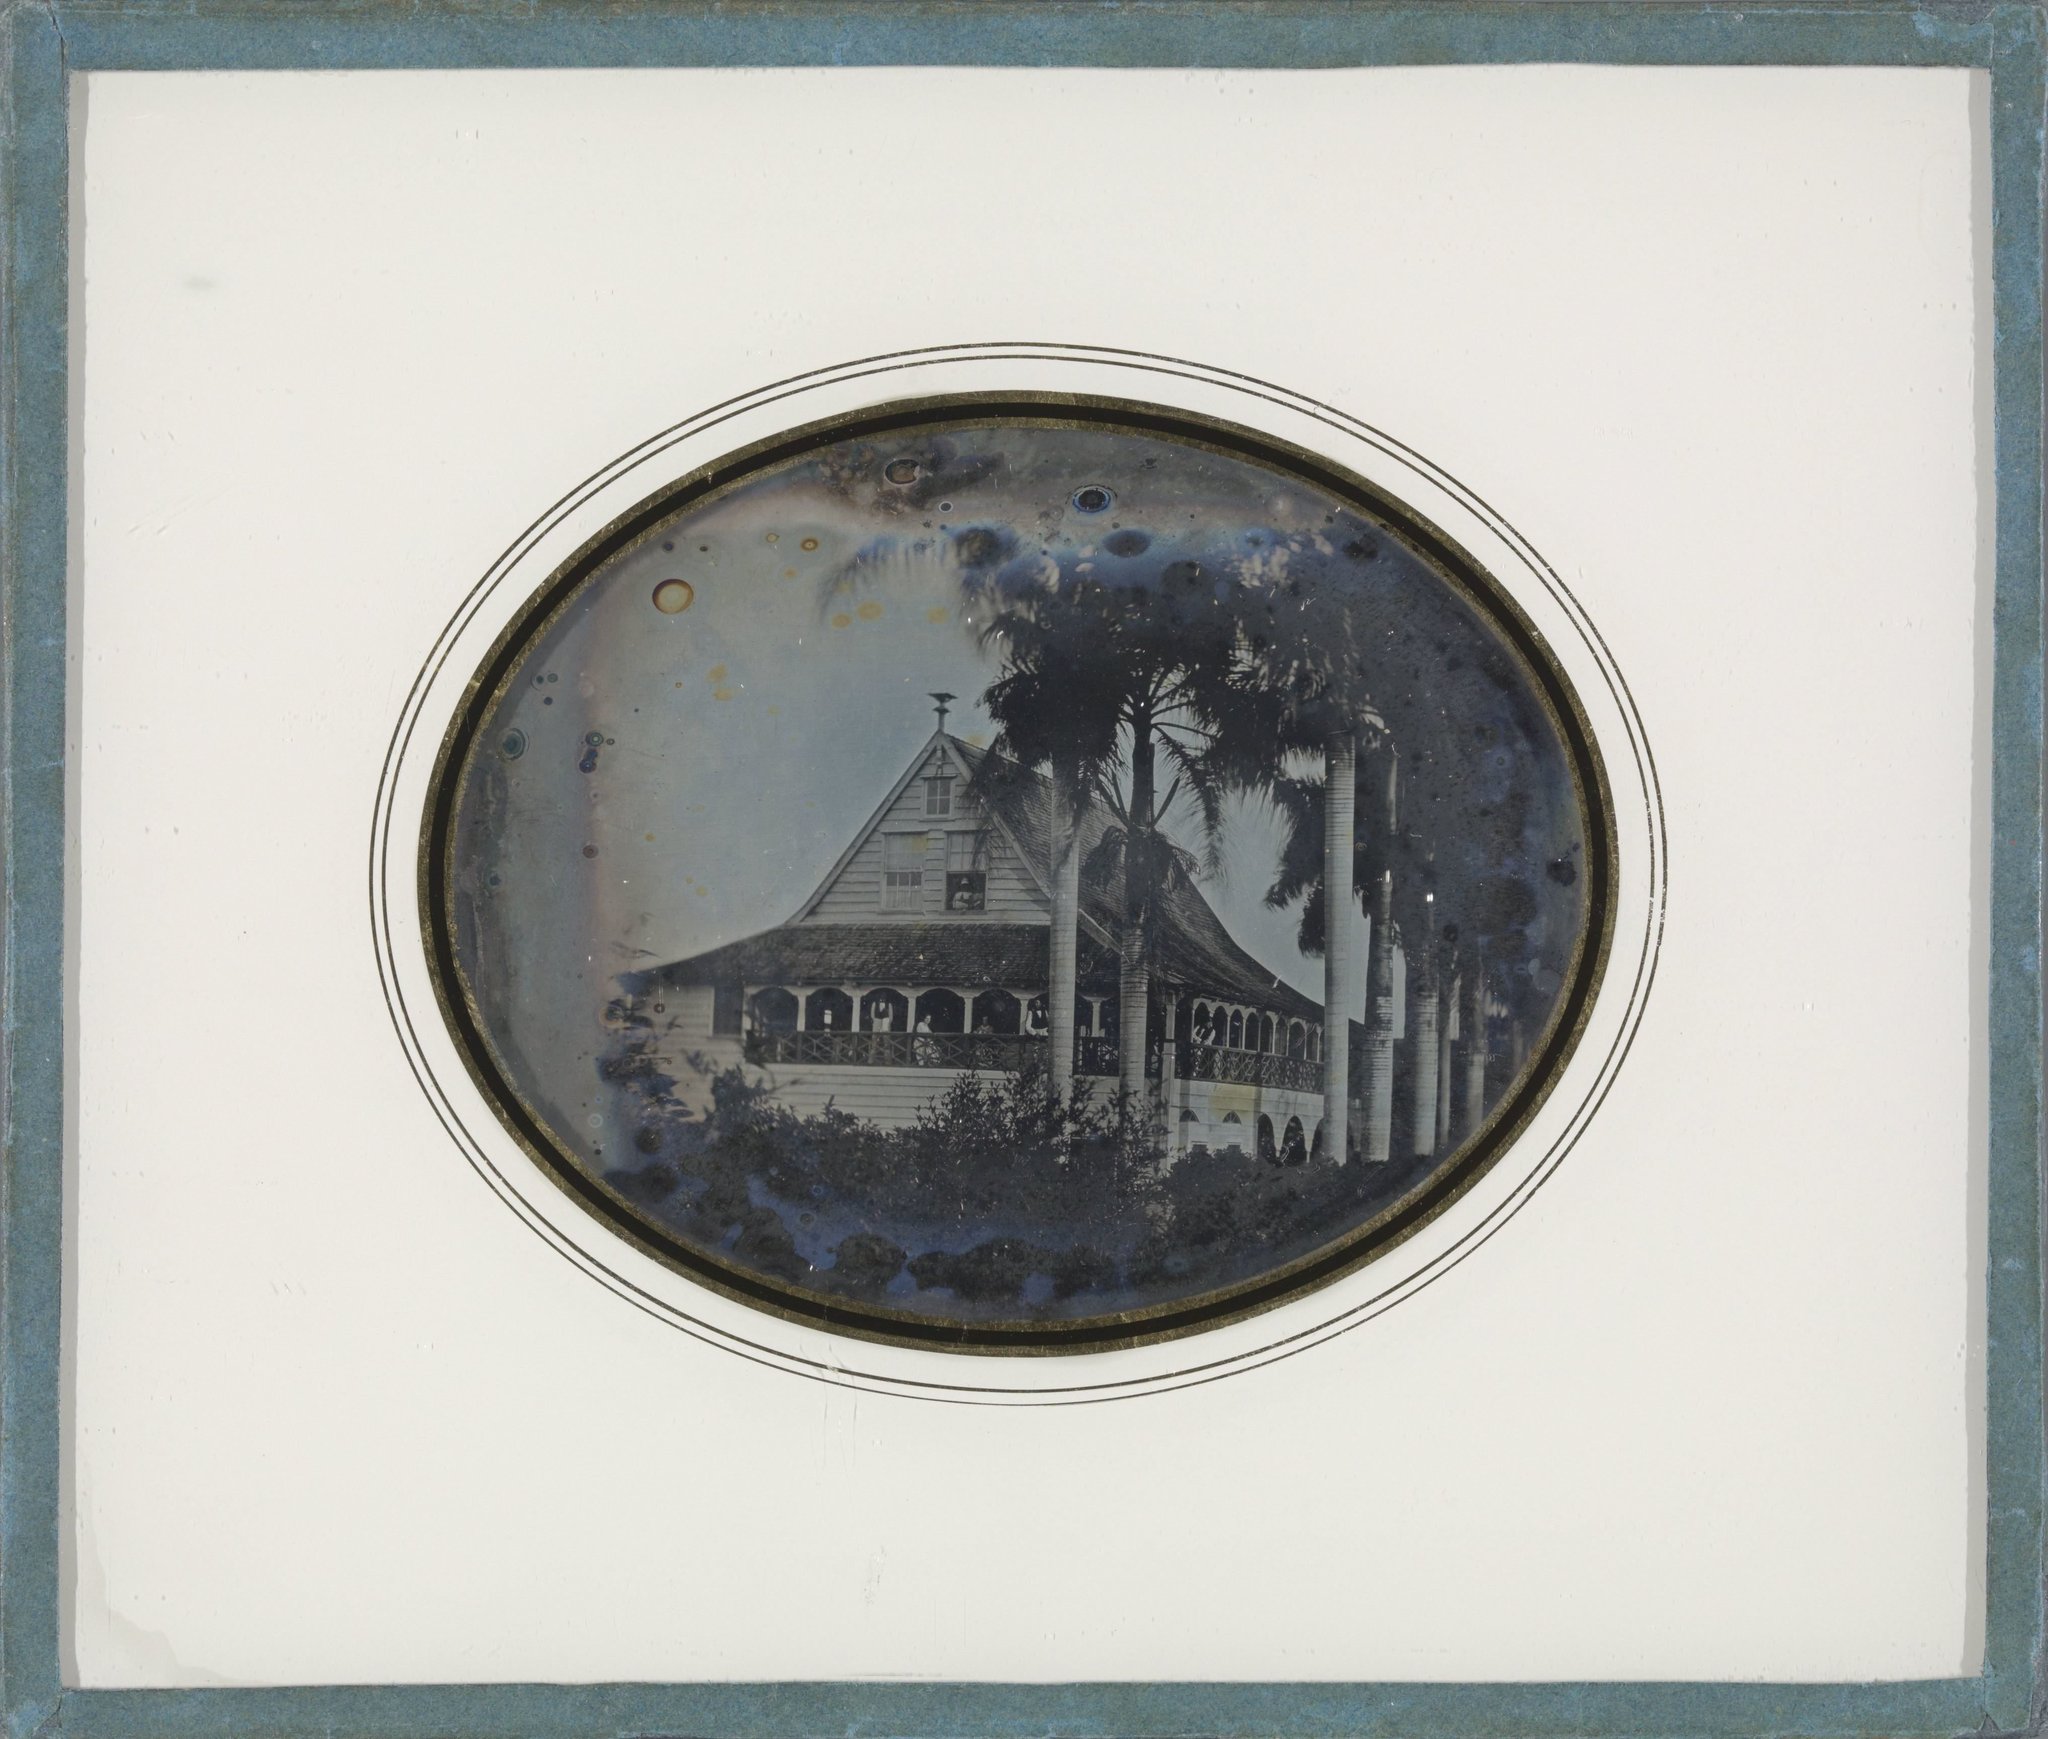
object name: photograph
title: Gezigt van het Buiten van F.L. Pichot, in de voorstad Zeelandia, Suriname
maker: Anonymous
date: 1845-1850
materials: copper, glass, paper, silver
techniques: daguerreotype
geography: paramaribo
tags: paramaribo (stad), fort zeelandia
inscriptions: inscription: ‘Gezigt van het Buiten van F. L. Pichot, te Suriname groot een morgenlands - genomen [...] de Zuid-West-zijde -- Eerste [...] aan de Voorstad Zeelandia - NB de Voorstad Zeelandia is [ge....] Tuinstad, een uur gaans...omtrek, met circa 80 huizen’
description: Gezicht op het buitenhuis van F.L. Pichot van de zuid-westzijde, Zeelandia, Suriname in ovale passe-partout. Op de veranda zijn mensen.